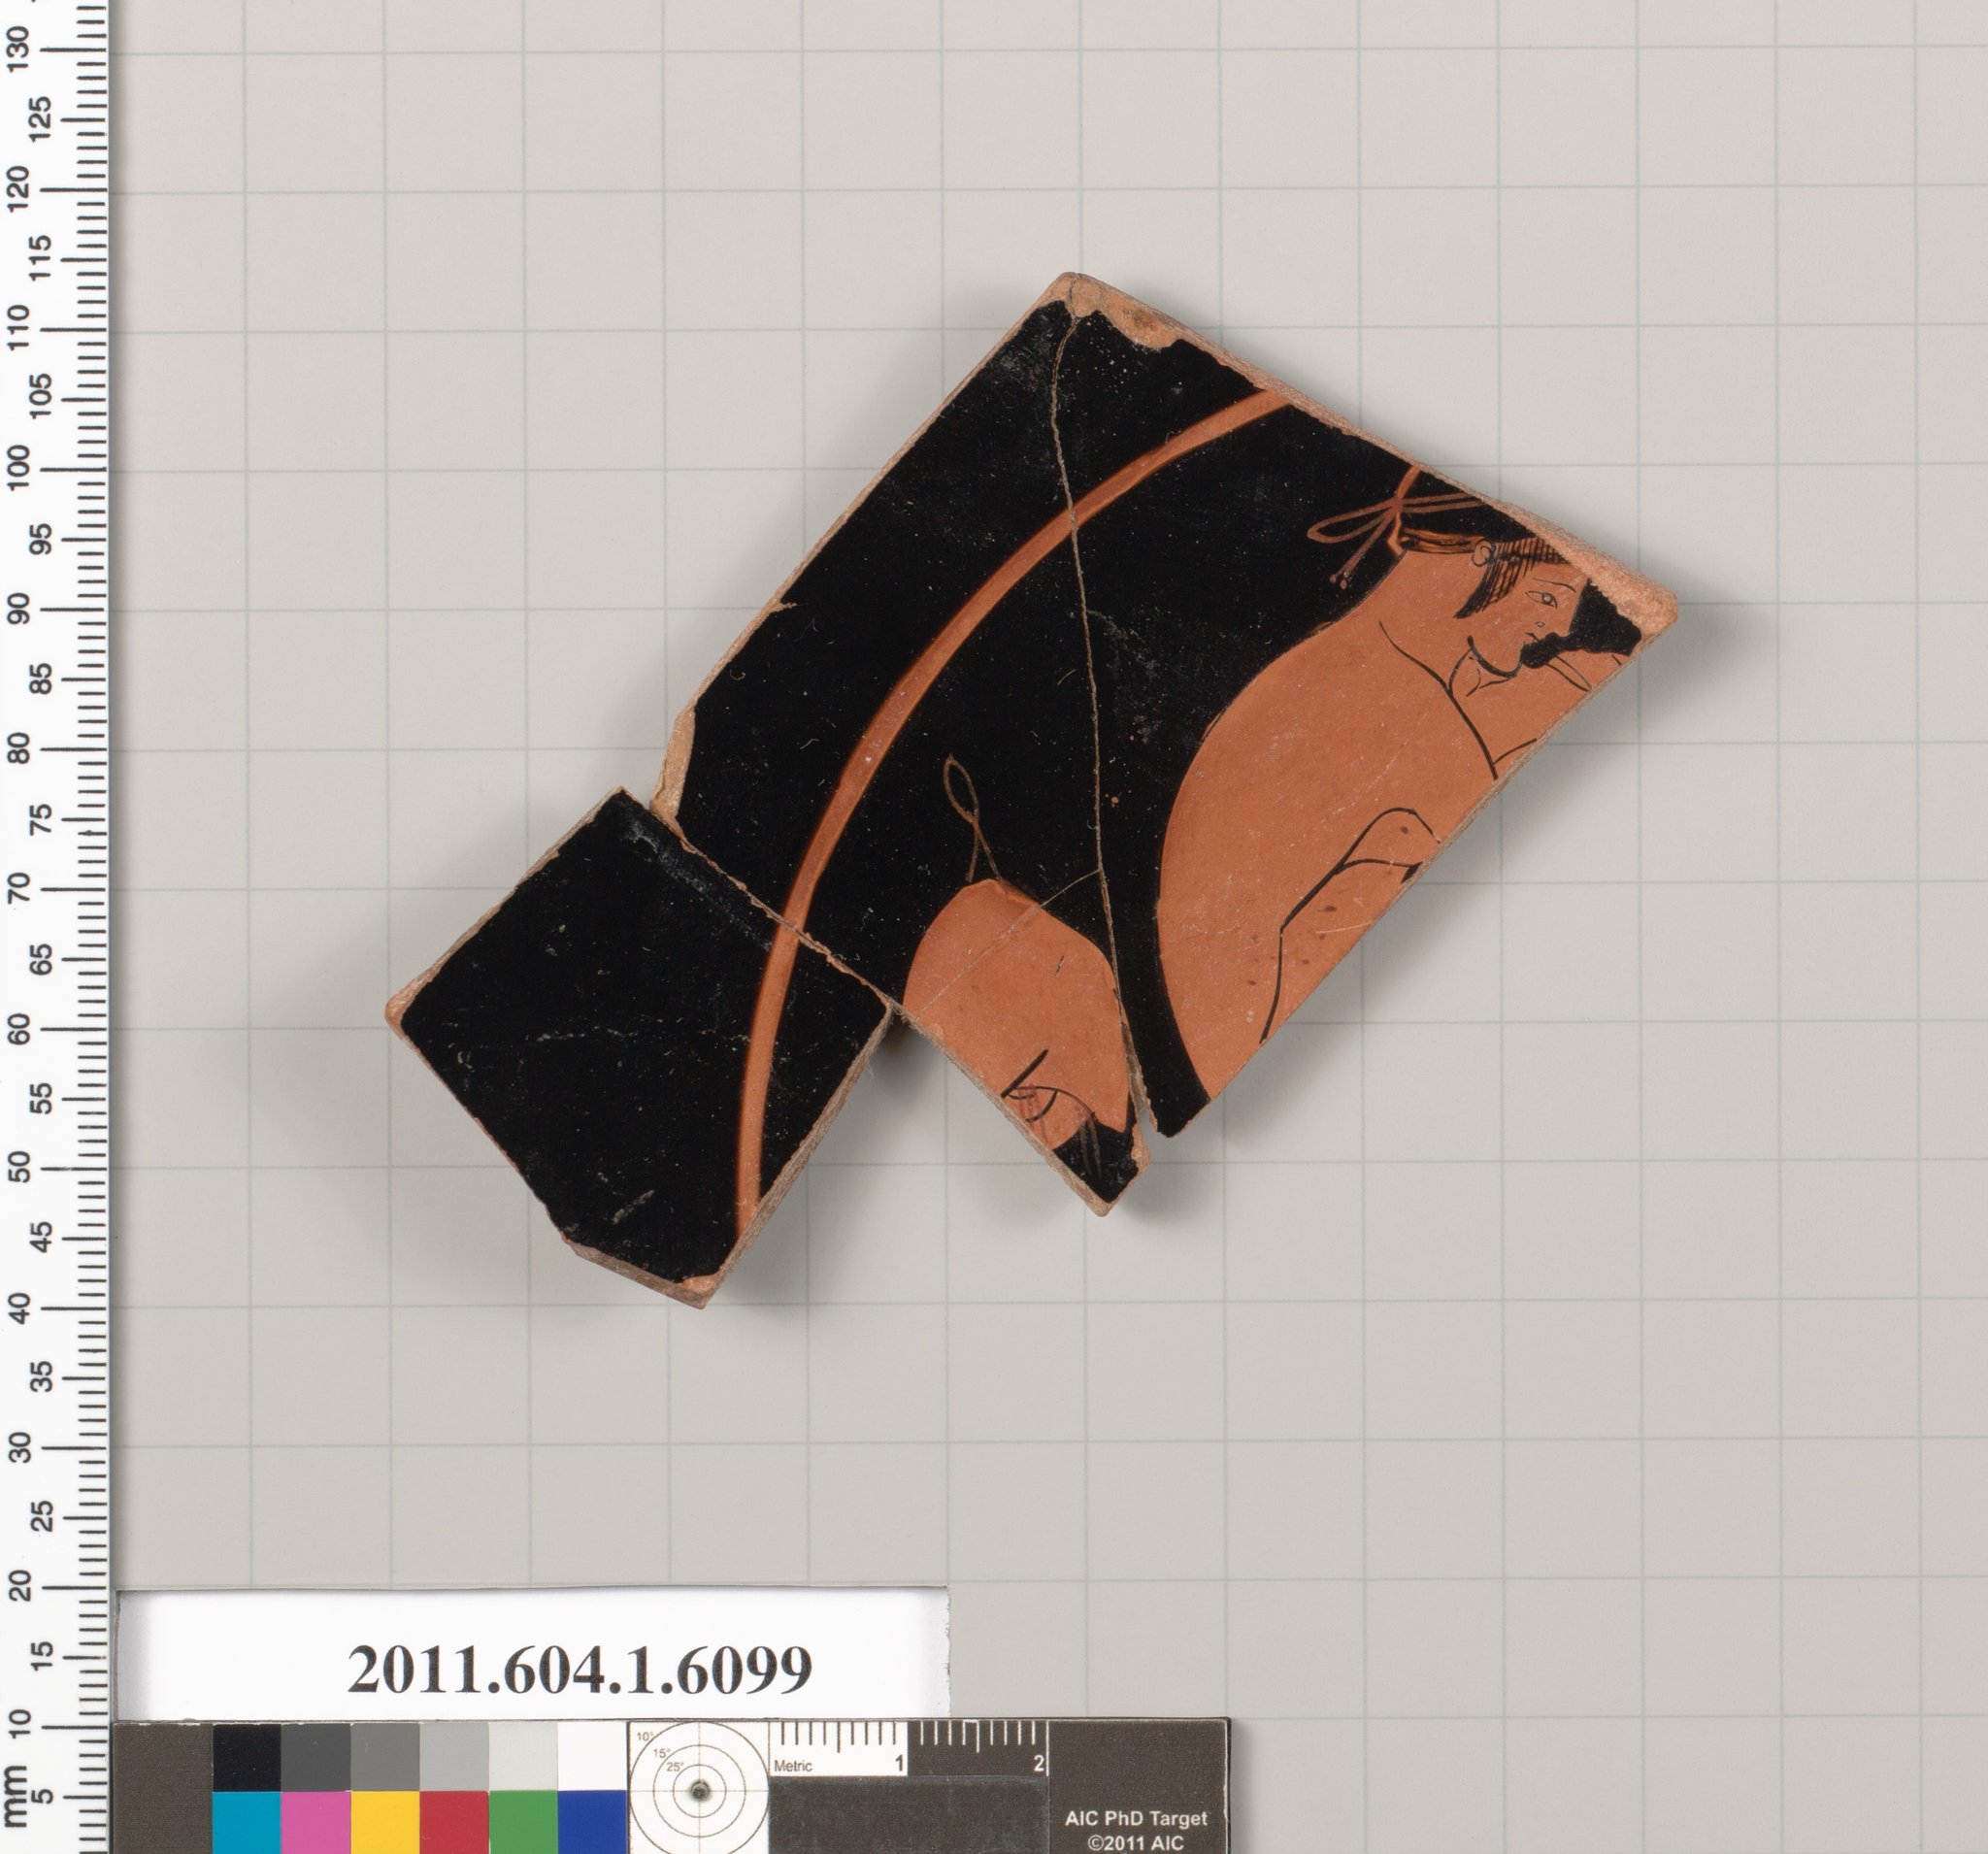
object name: kylix fragment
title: Terracotta fragment of a kylix (drinking cup)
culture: greek, attic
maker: apollodoros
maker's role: artist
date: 500-490 BCE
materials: terracotta